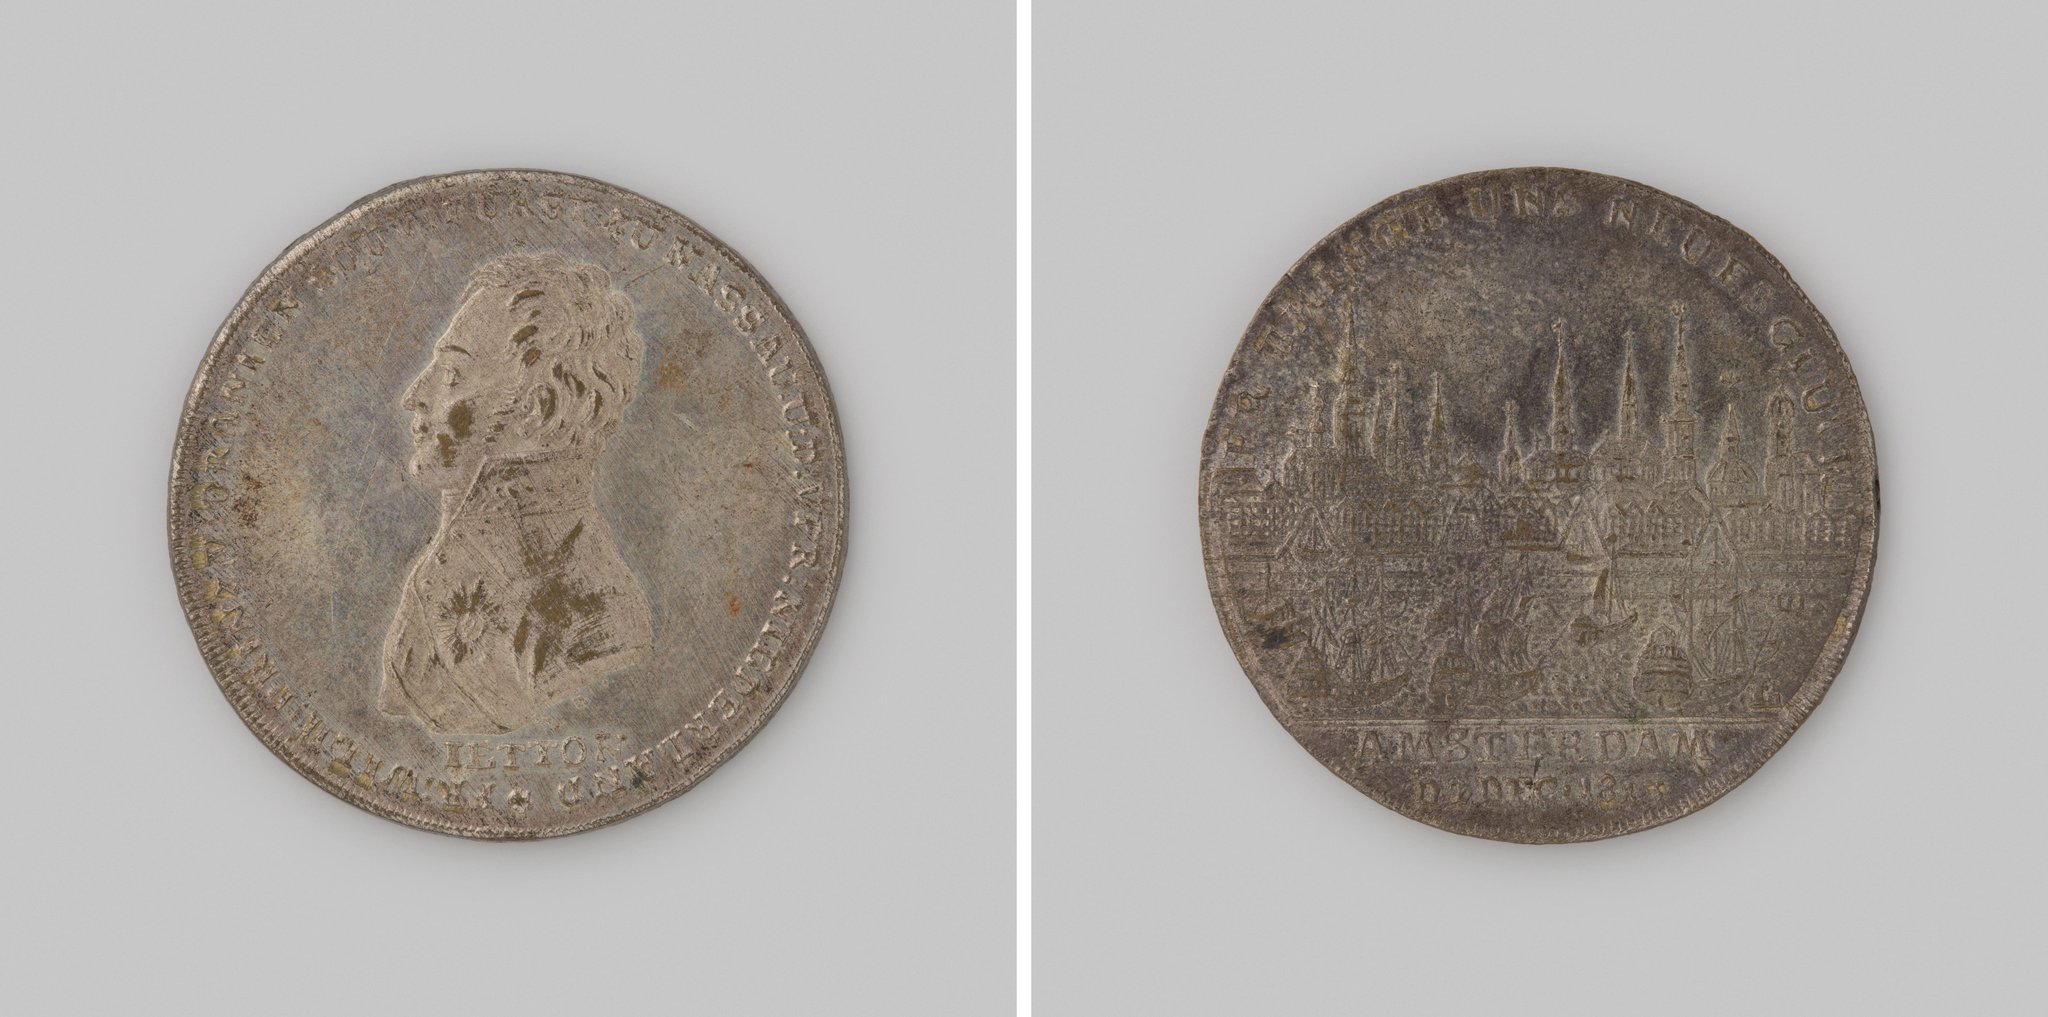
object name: history medal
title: Frederik Willem van Oranje Souverein Vorst der Nederlanden 1813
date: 1813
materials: brass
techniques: striking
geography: nuremberg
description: Verzilverde penning, op de voorzijde het borstbeeld van Willem Frederik naar links waaronder IETTON, met omschrift, op de keerzijde het aanzicht van Amsterdam vanaf het IJ, met omschrift en afsnedetekst.